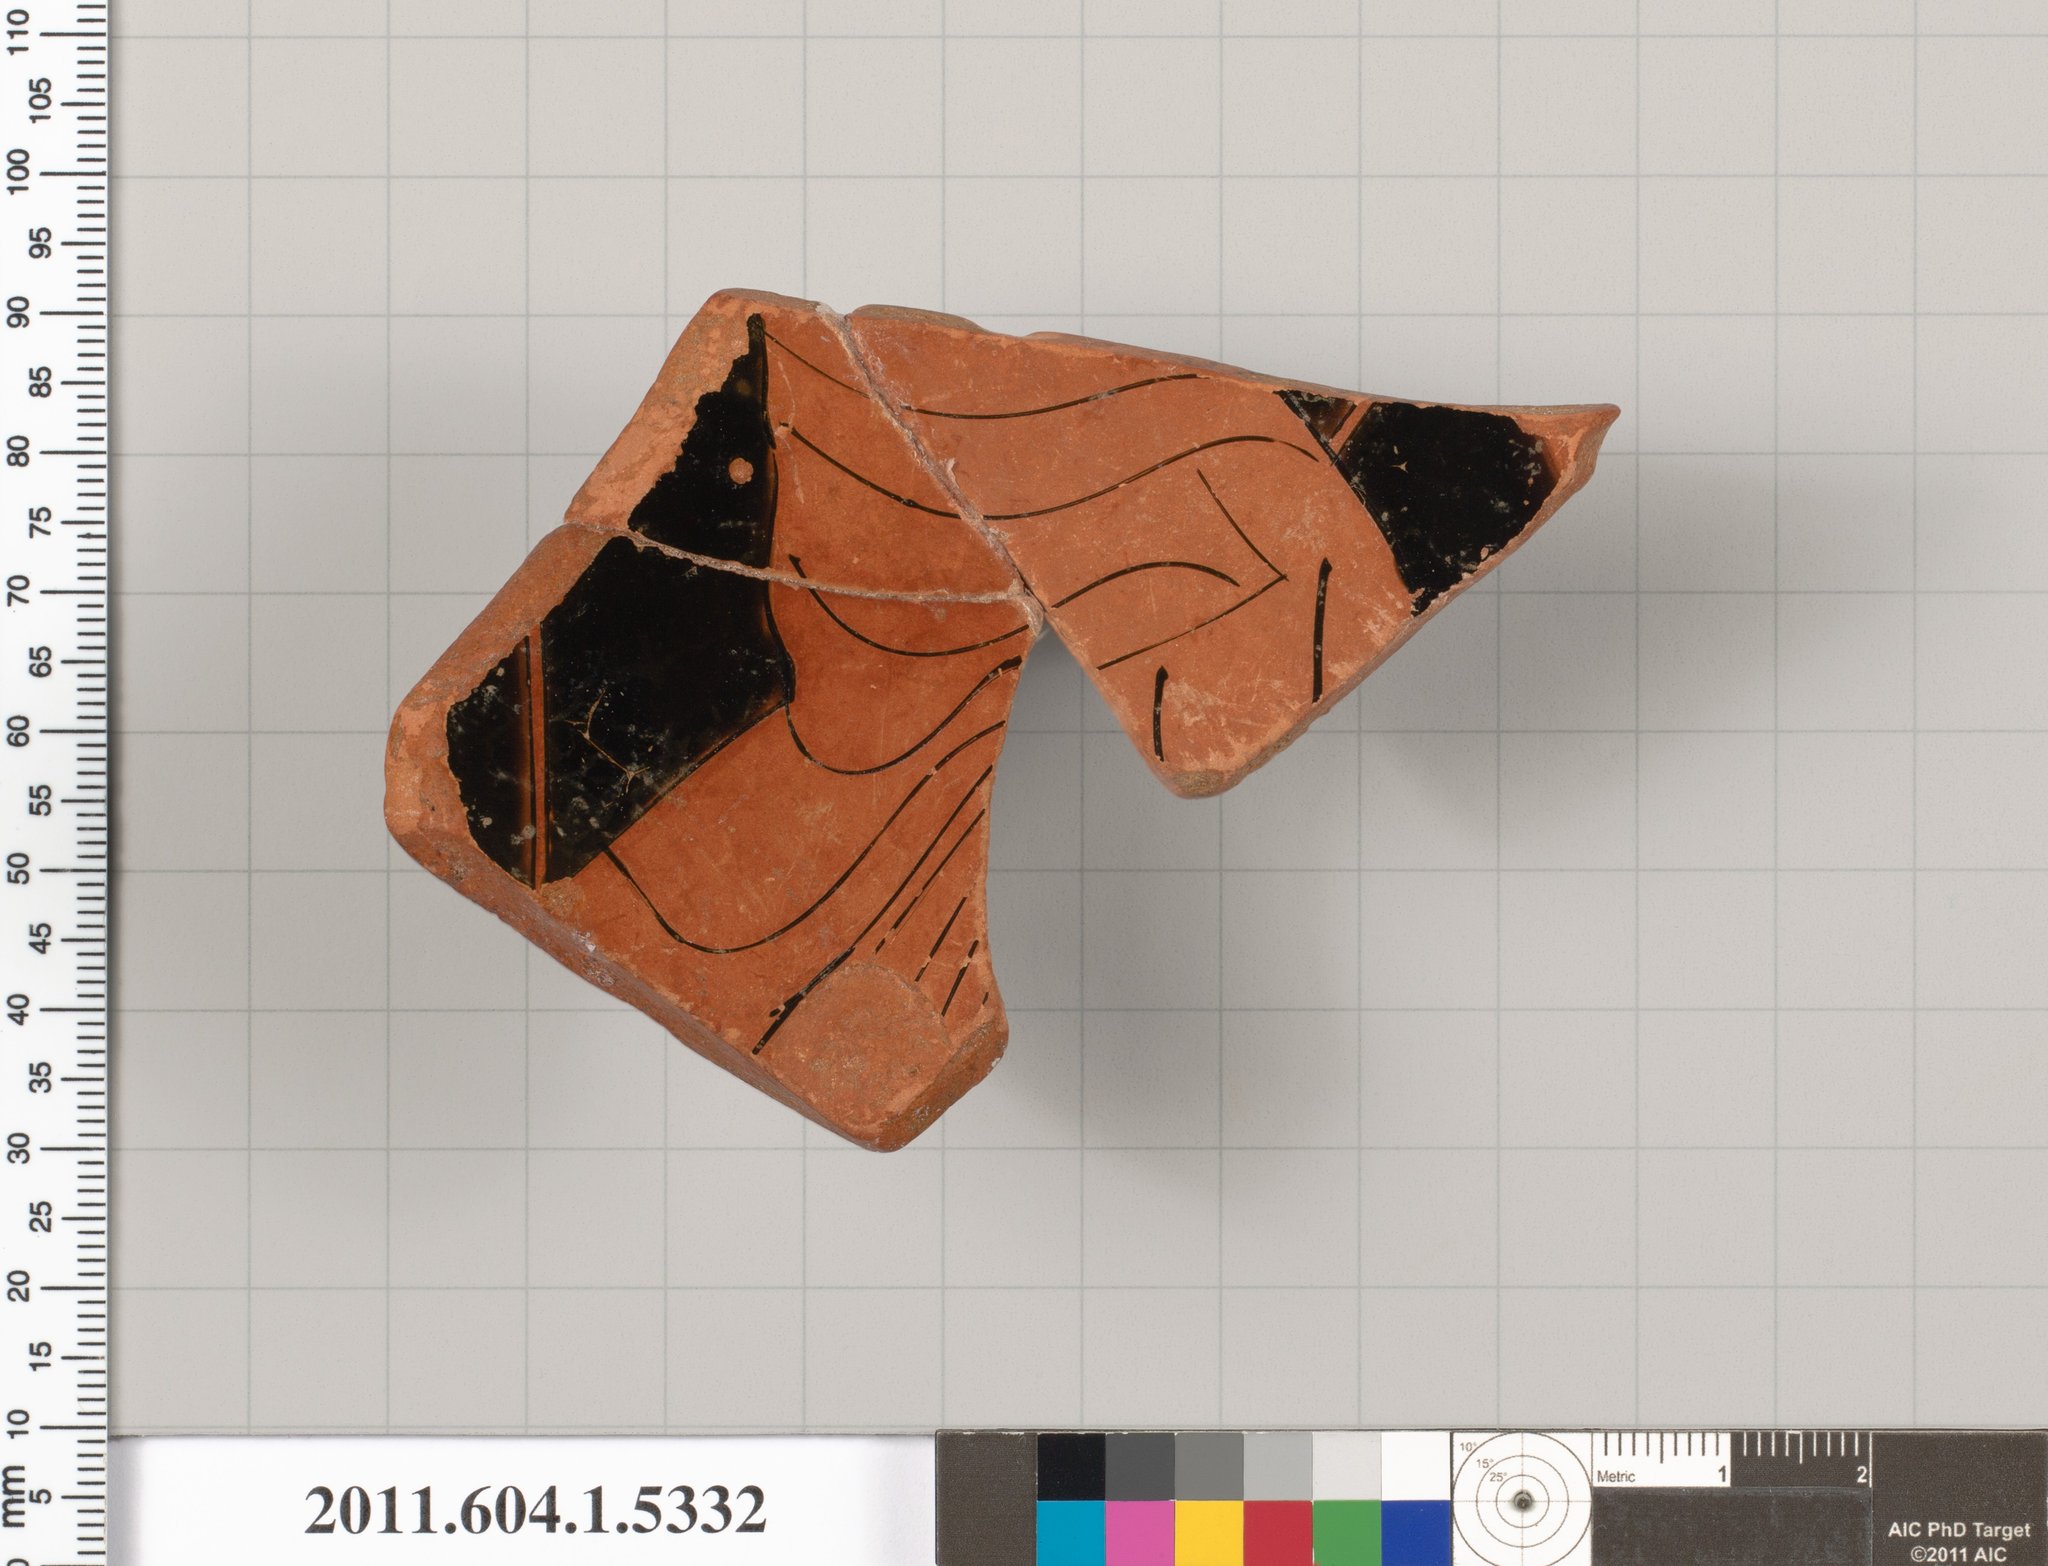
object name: kylix fragment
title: Terracotta fragment of a kylix (drinking cup)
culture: greek, attic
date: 500-480 BCE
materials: terracotta